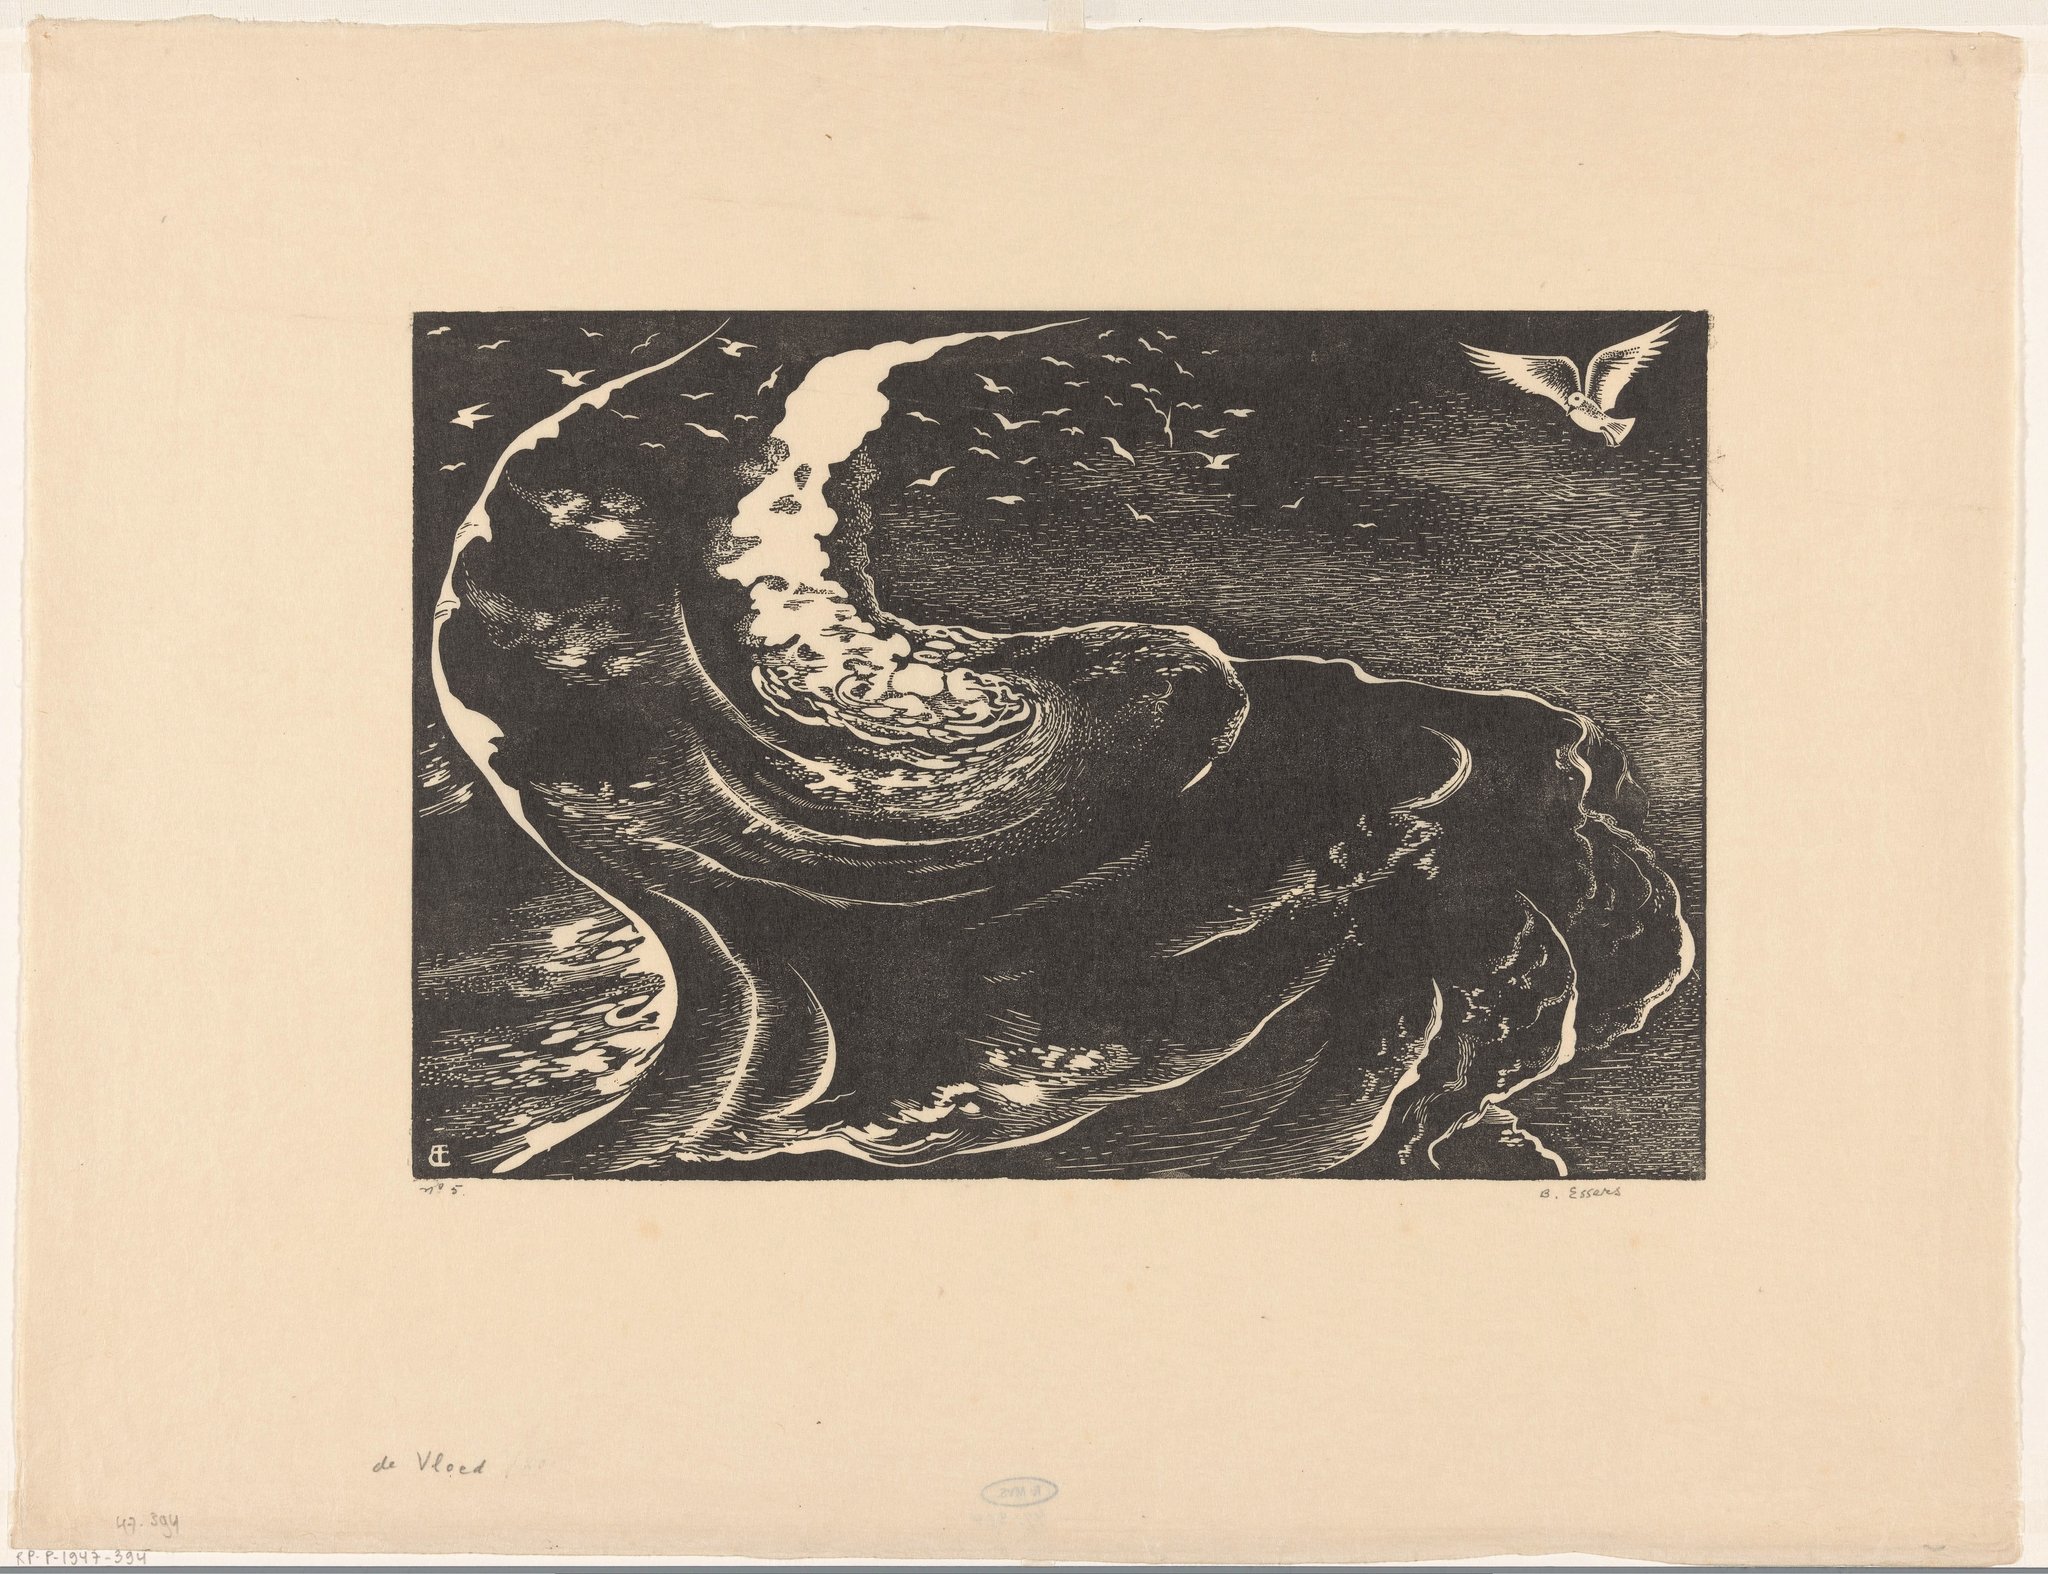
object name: print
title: De vloed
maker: bernard essers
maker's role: print maker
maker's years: 1893-1945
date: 1940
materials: paper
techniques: engraving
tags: flood, high tide, shore-birds and wading-birds: gull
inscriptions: collector's mark: Lugt 2228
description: Meeuwen vliegend boven een golf die aanspoelt op een strand.